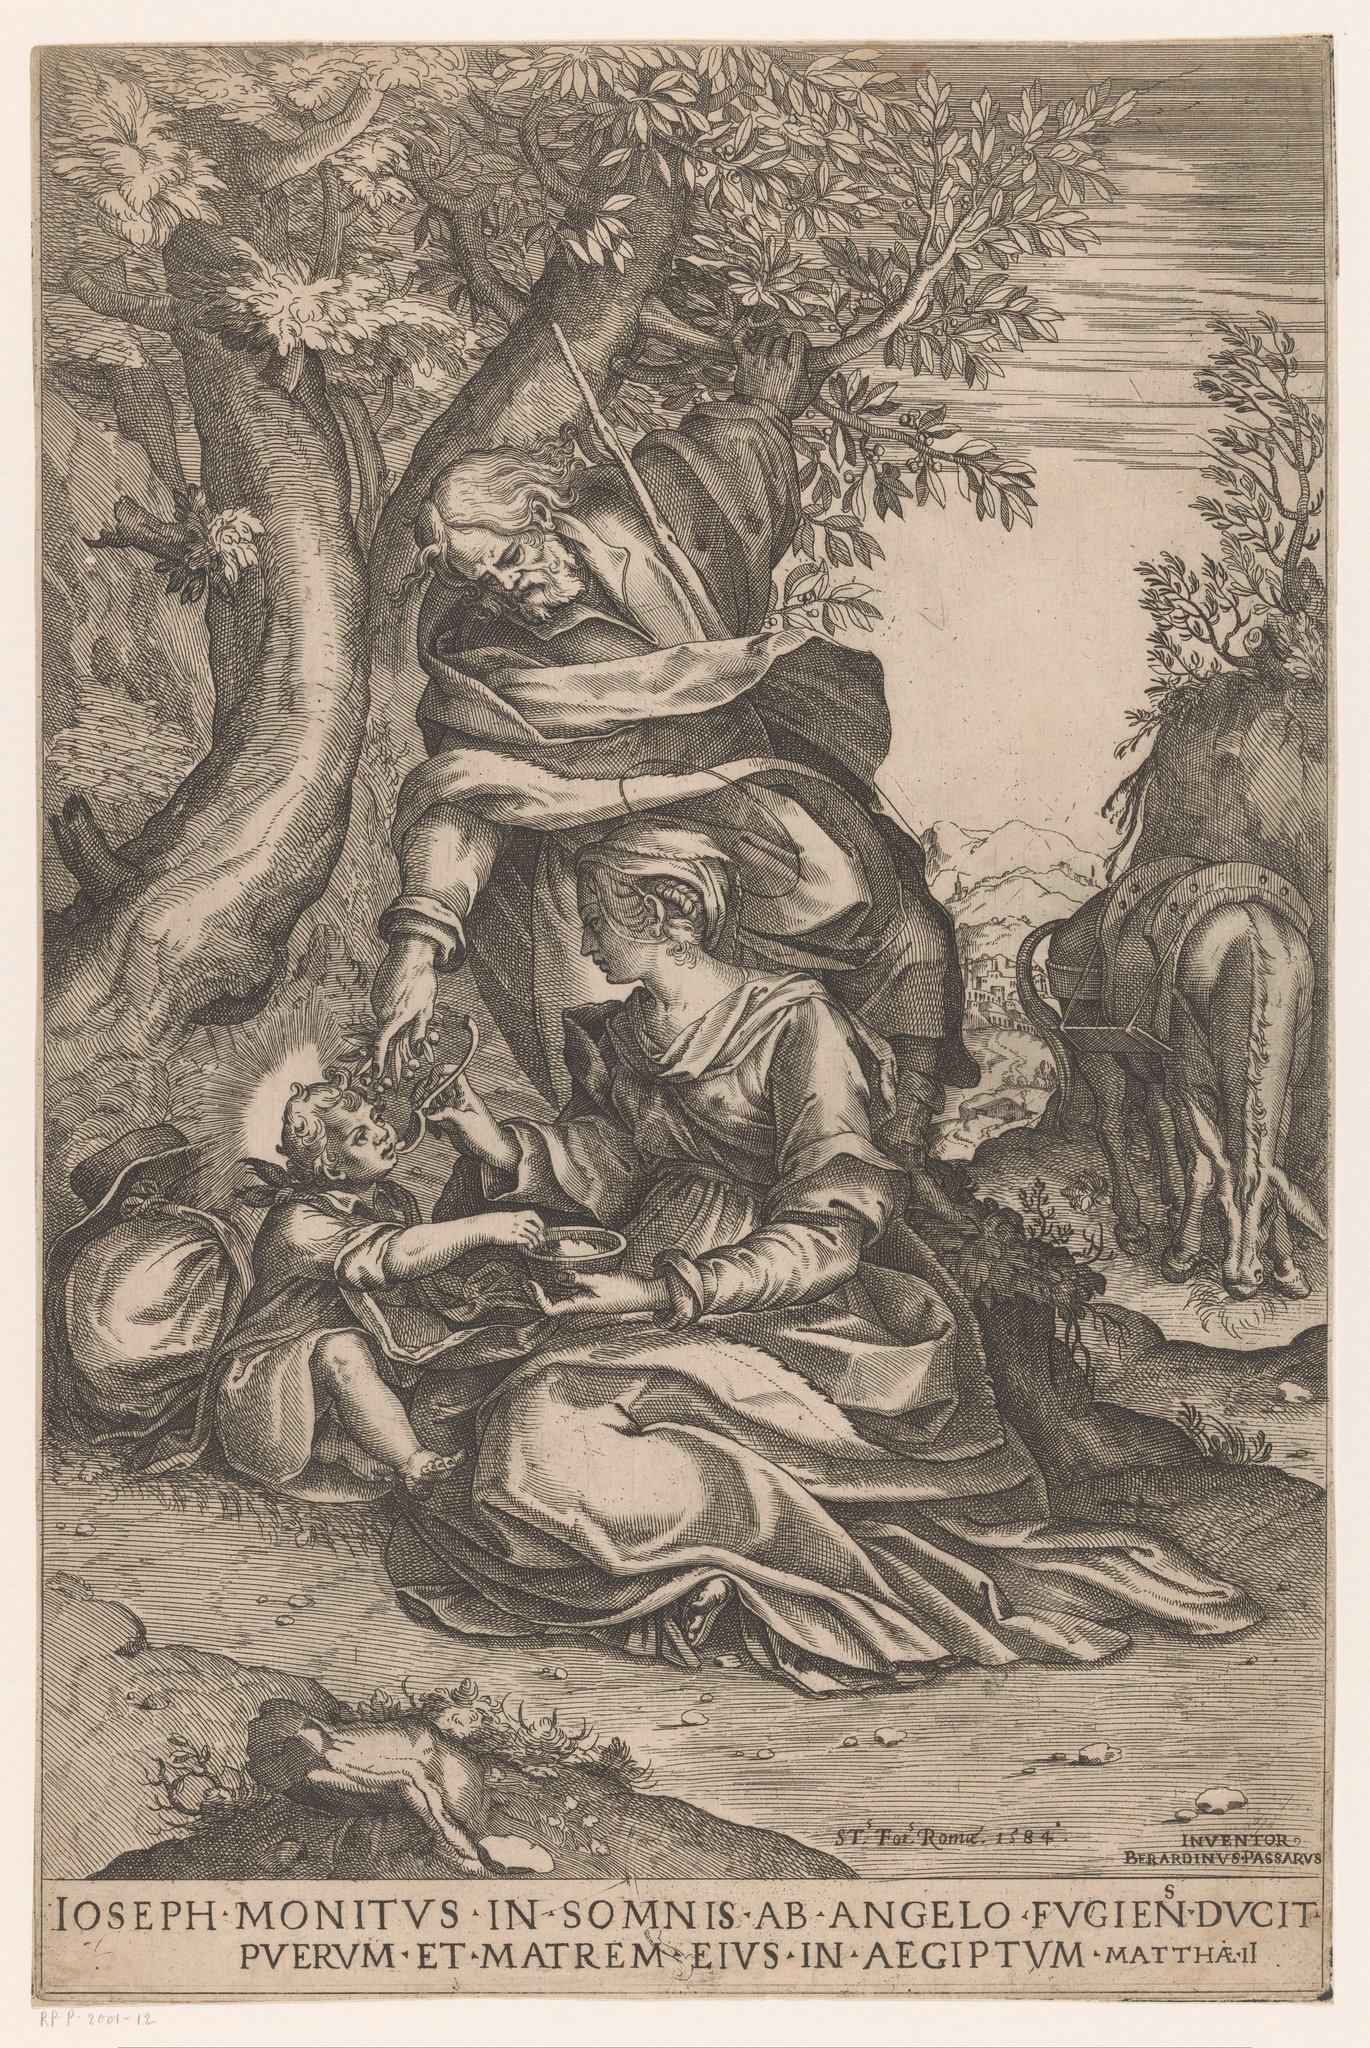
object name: print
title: Rust op de vlucht naar Egypte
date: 1584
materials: paper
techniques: engraving, etching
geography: rome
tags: trees: cherry-tree, rest on the flight into egypt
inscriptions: inscription: ‘[...] zz.’, number: ‘151’, collector's mark: Lugt 2760, collector's mark: Lugt 2228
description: De Heilige Familie rust onder een kersenboom tijdens de vlucht naar Egypte. Maria voert het Christuskind met een lepel. Jozef staat achter hen en reikt een tros kersen aan. Rechts staat de ezel te grazen. In de ondermarge twee regels tekst in het Latijn.